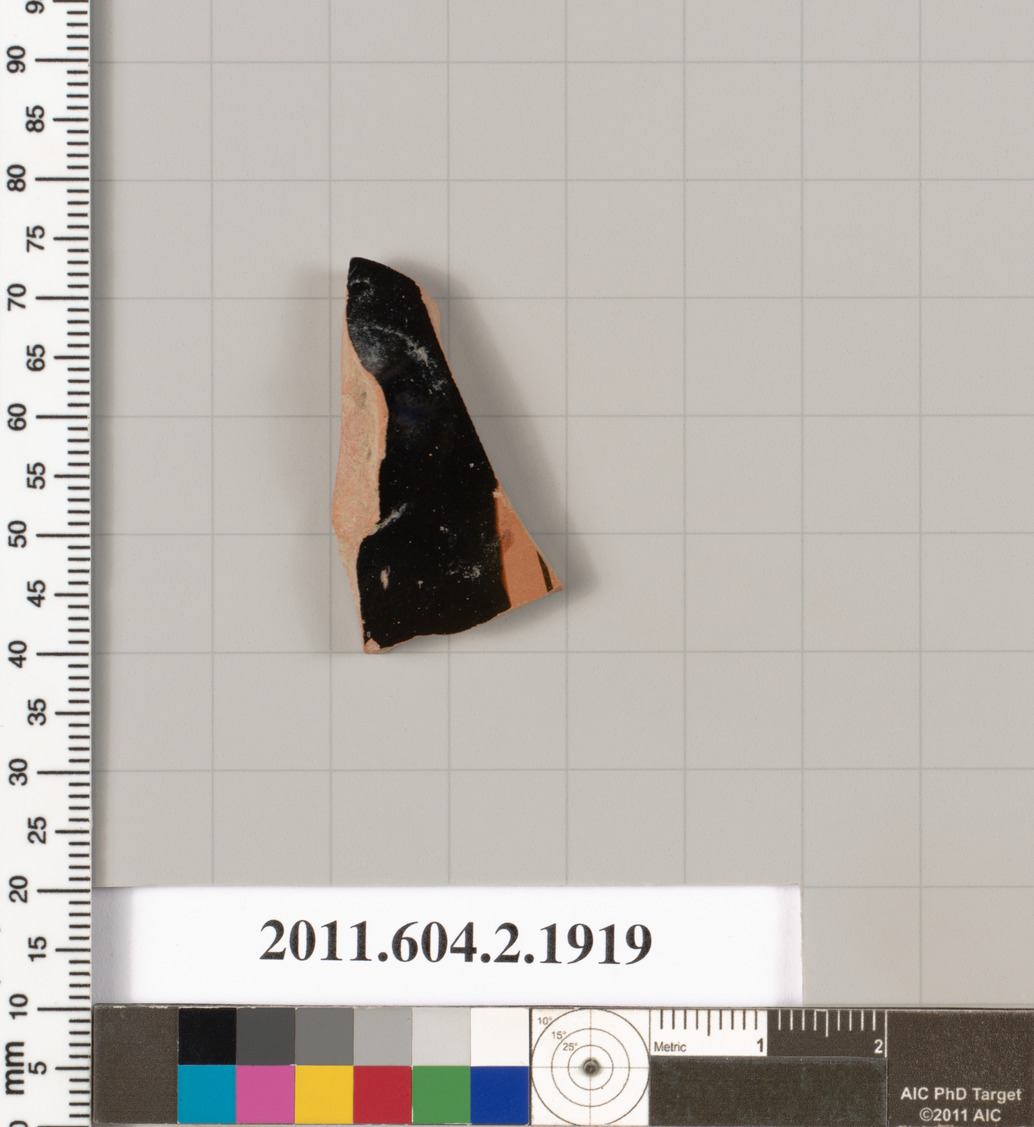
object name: skyphos fragment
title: Terracotta fragment of a skyphos (deep drinking cup)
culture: greek, attic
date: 460-430 BCE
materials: terracotta